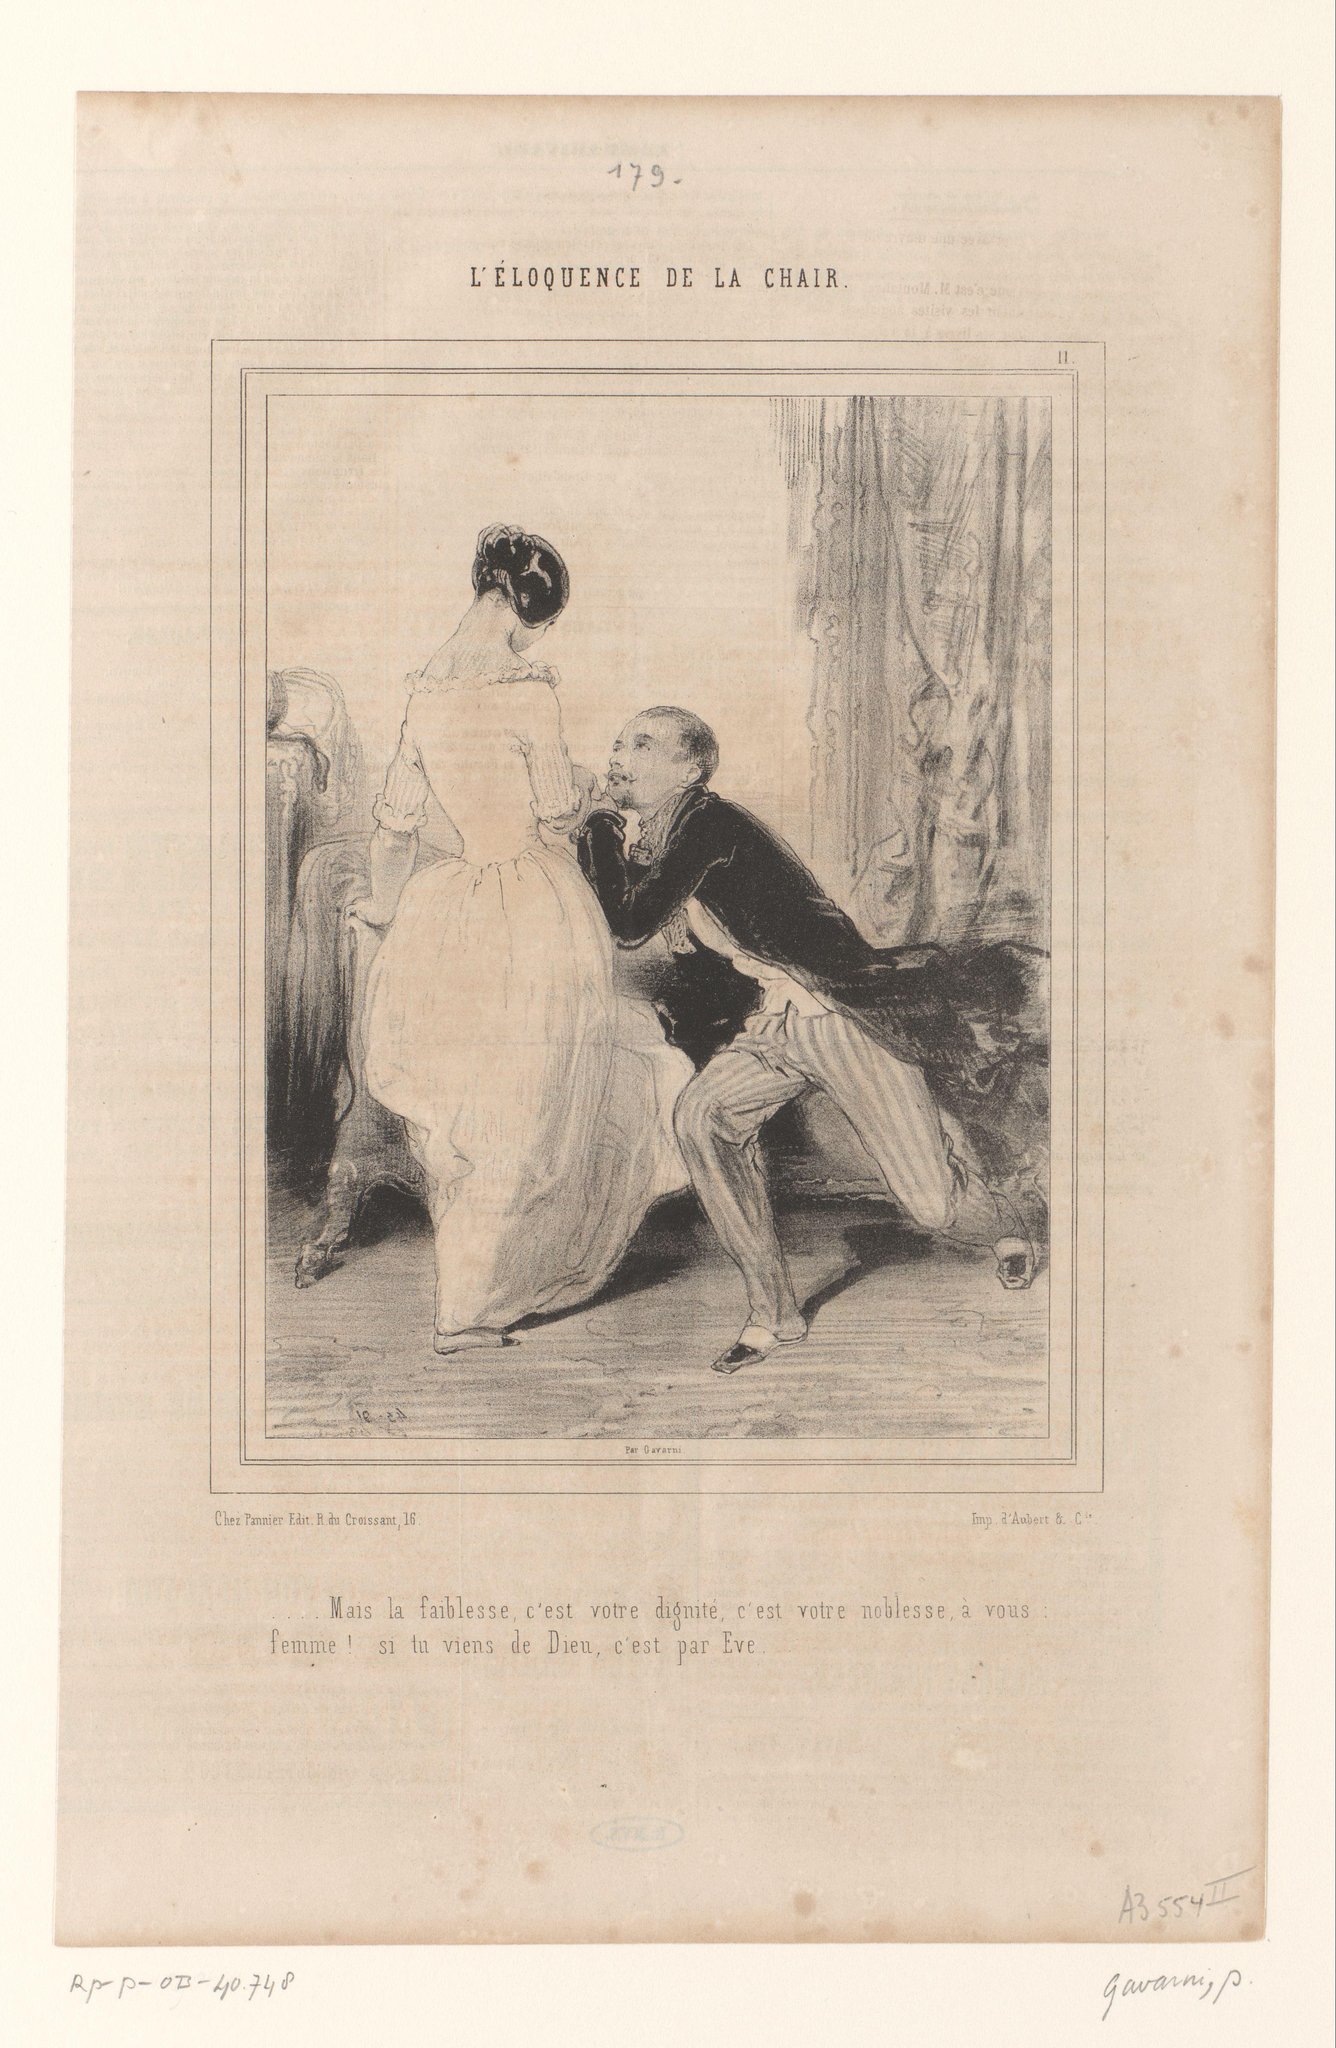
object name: print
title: L'éloquence de la chair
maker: paul gavarni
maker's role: draughtsman, print maker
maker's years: 1804-1866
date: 1843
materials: paper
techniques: lithograph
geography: paris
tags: kneeling figure, man kneeling before his beloved (proposing), gripping someone by the hand or the wrist; clasped hands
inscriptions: collector's mark: Lugt 2228a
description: Prent gebruikt voor: Le Charivari, 26 september 1843.